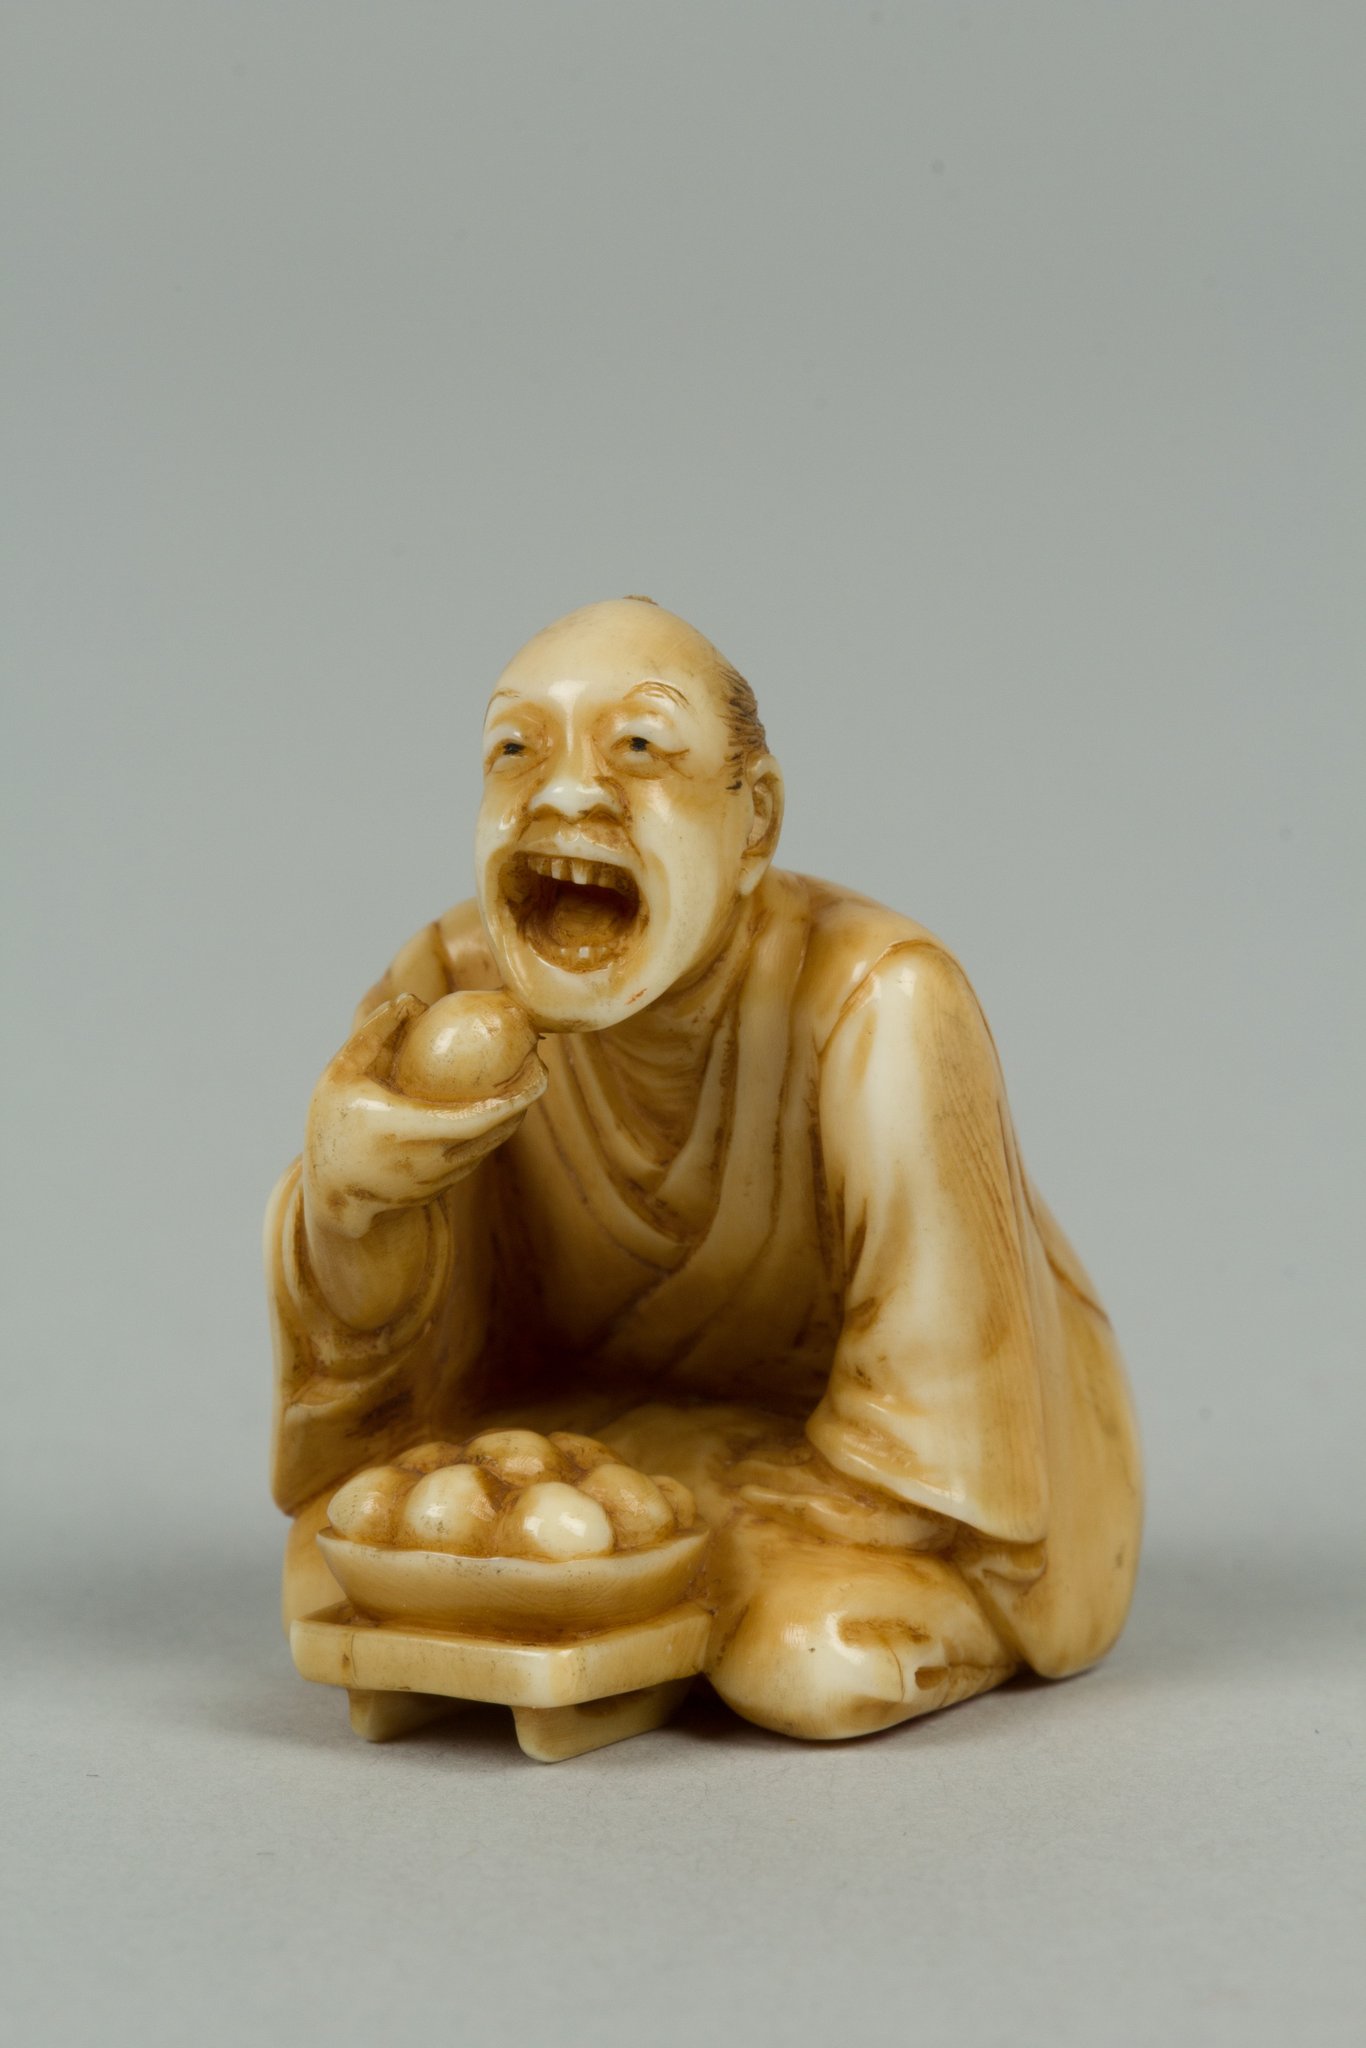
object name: netsuke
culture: japanese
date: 1701-1800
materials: ivory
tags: men